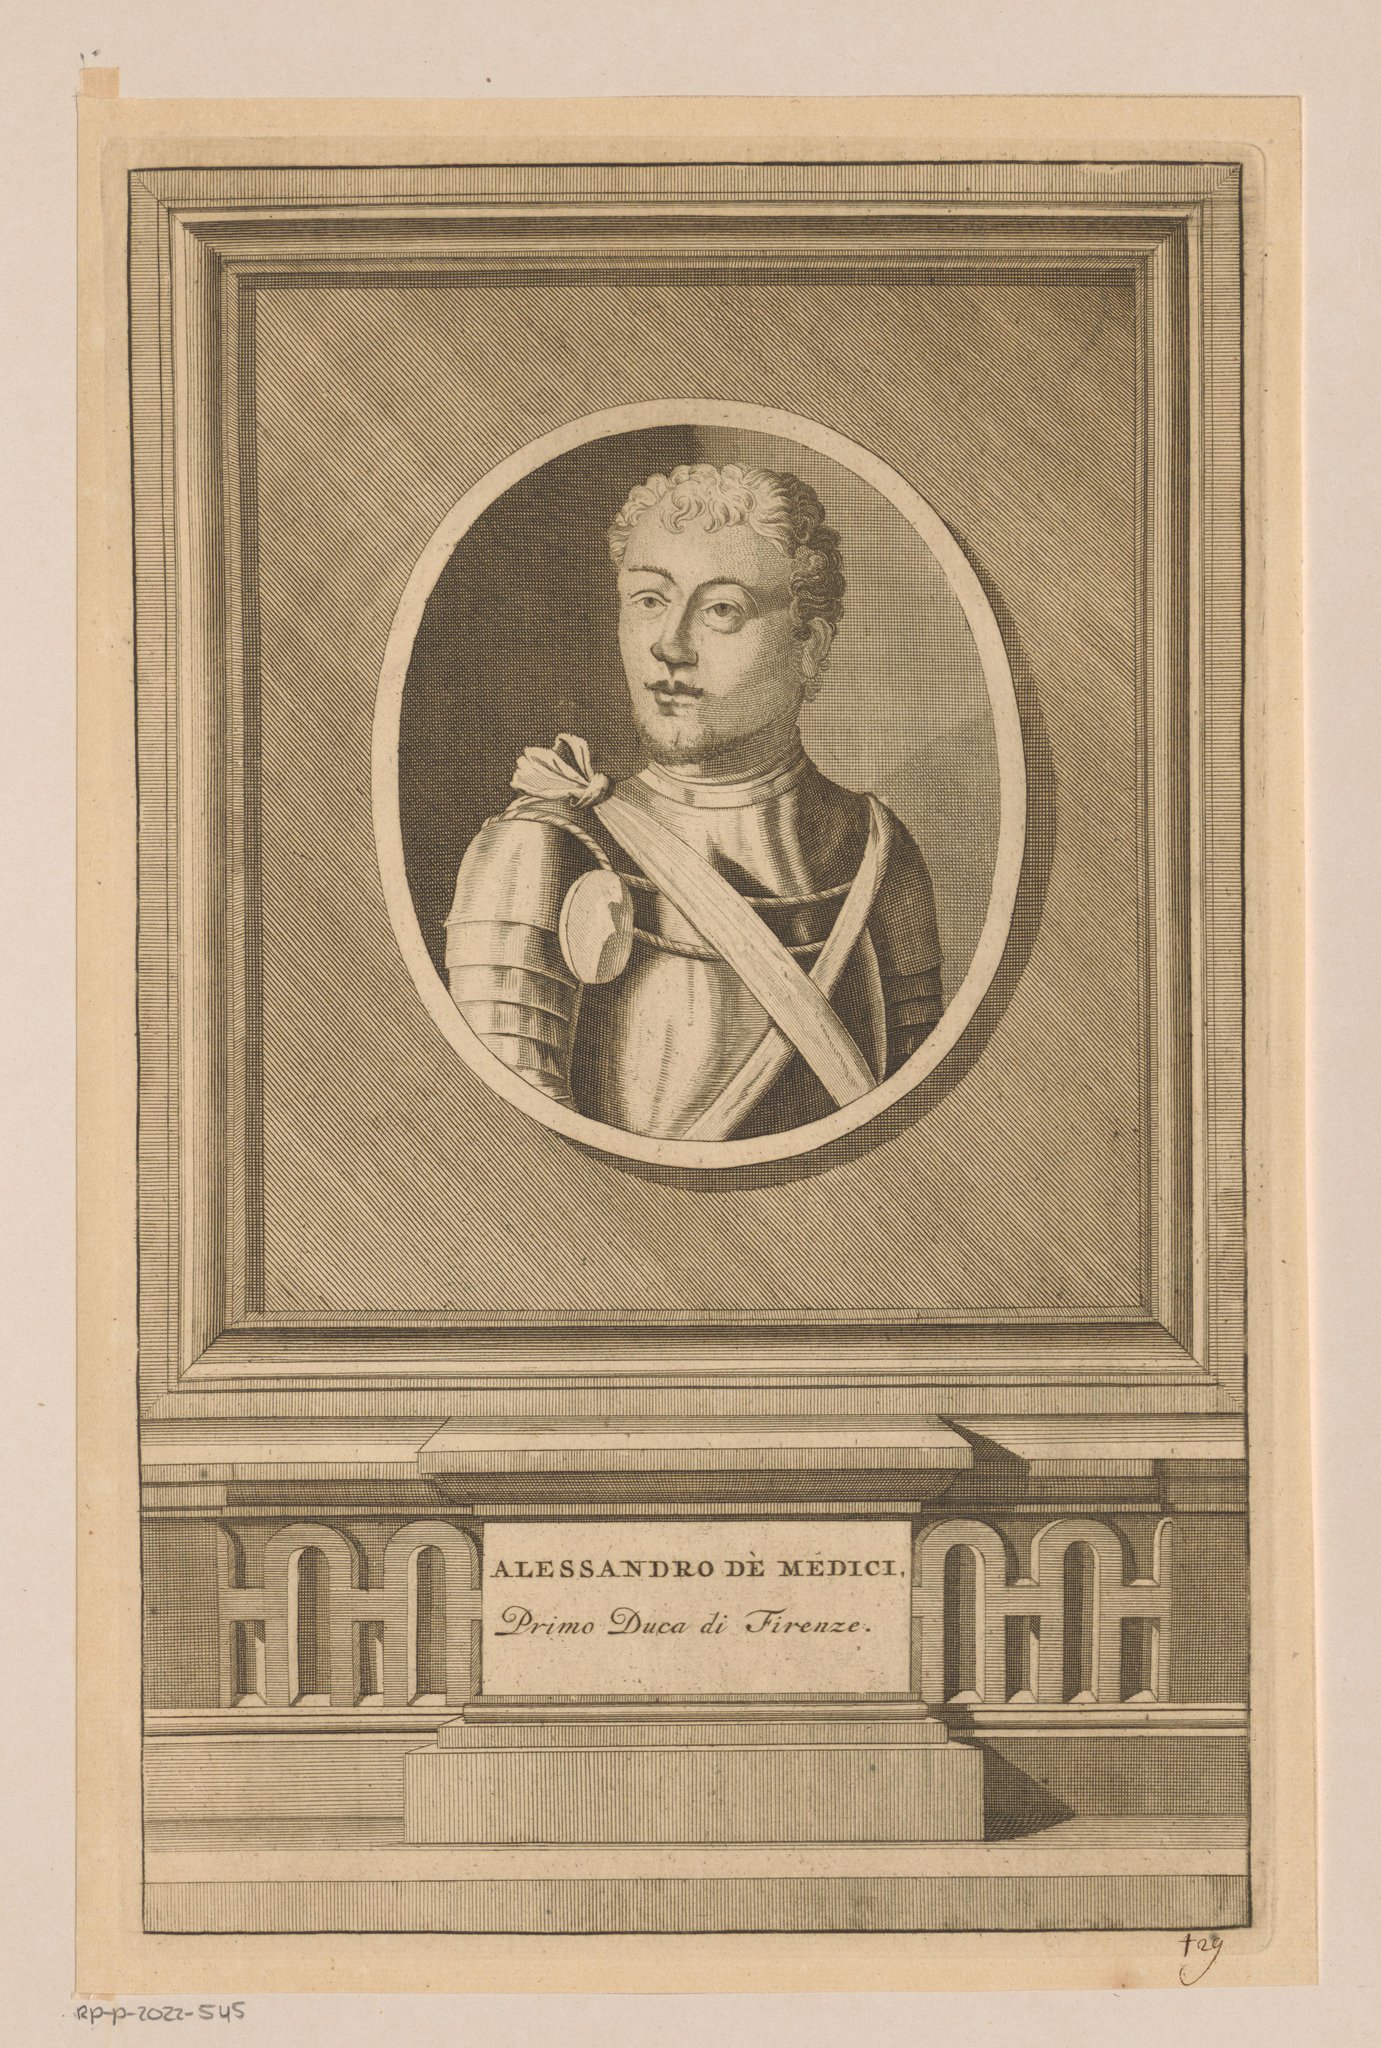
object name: print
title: Alessandro dè Medici, Primo Duca di Firenze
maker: Anonymous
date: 1715-1730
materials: paper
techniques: engraving, etching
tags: historical persons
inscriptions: inscription: ‘t29’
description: Prent waarschijnlijk uit: Cabinet de XLI. portraits des grands ducs, electeurs, archiducs, & autres princes & princesses. Leiden: Pieter van der Aa I, [ca. 1715-1730].